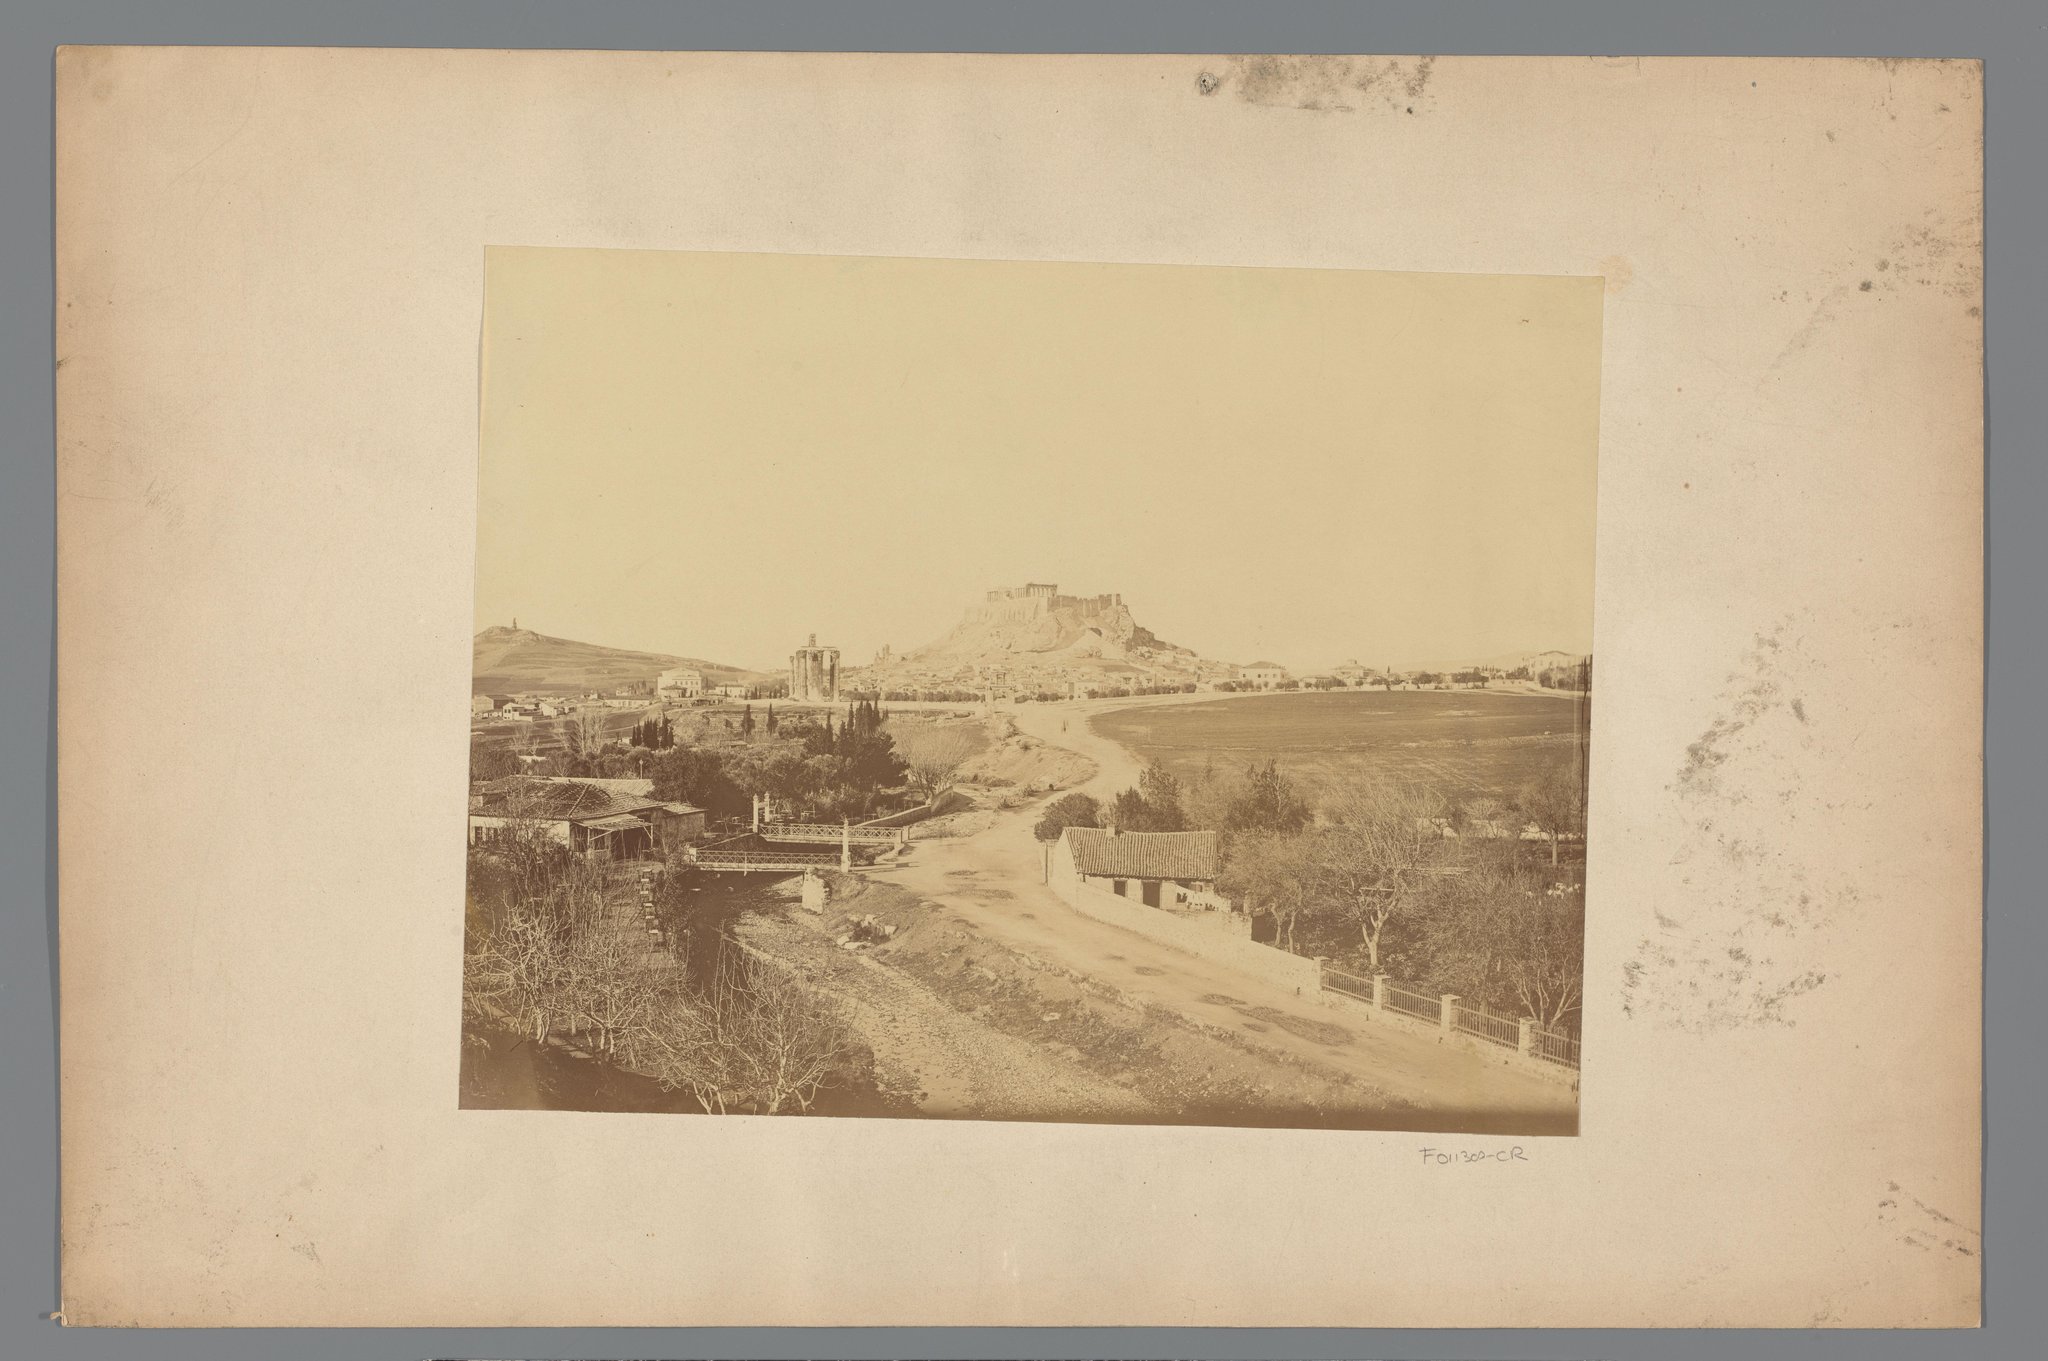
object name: photograph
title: Gezicht op de Akropolis met op de voorgrond een landweg en een tempelruïne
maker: Anonymous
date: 1860-1880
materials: photographic support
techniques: albumen print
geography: athens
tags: ruin of a building ~ architecture, road, path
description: Onderdeel van Reisalbum met opnames van kunstwerken en bezienswaardigheden in Italië, Griekenland en Frankrijk.